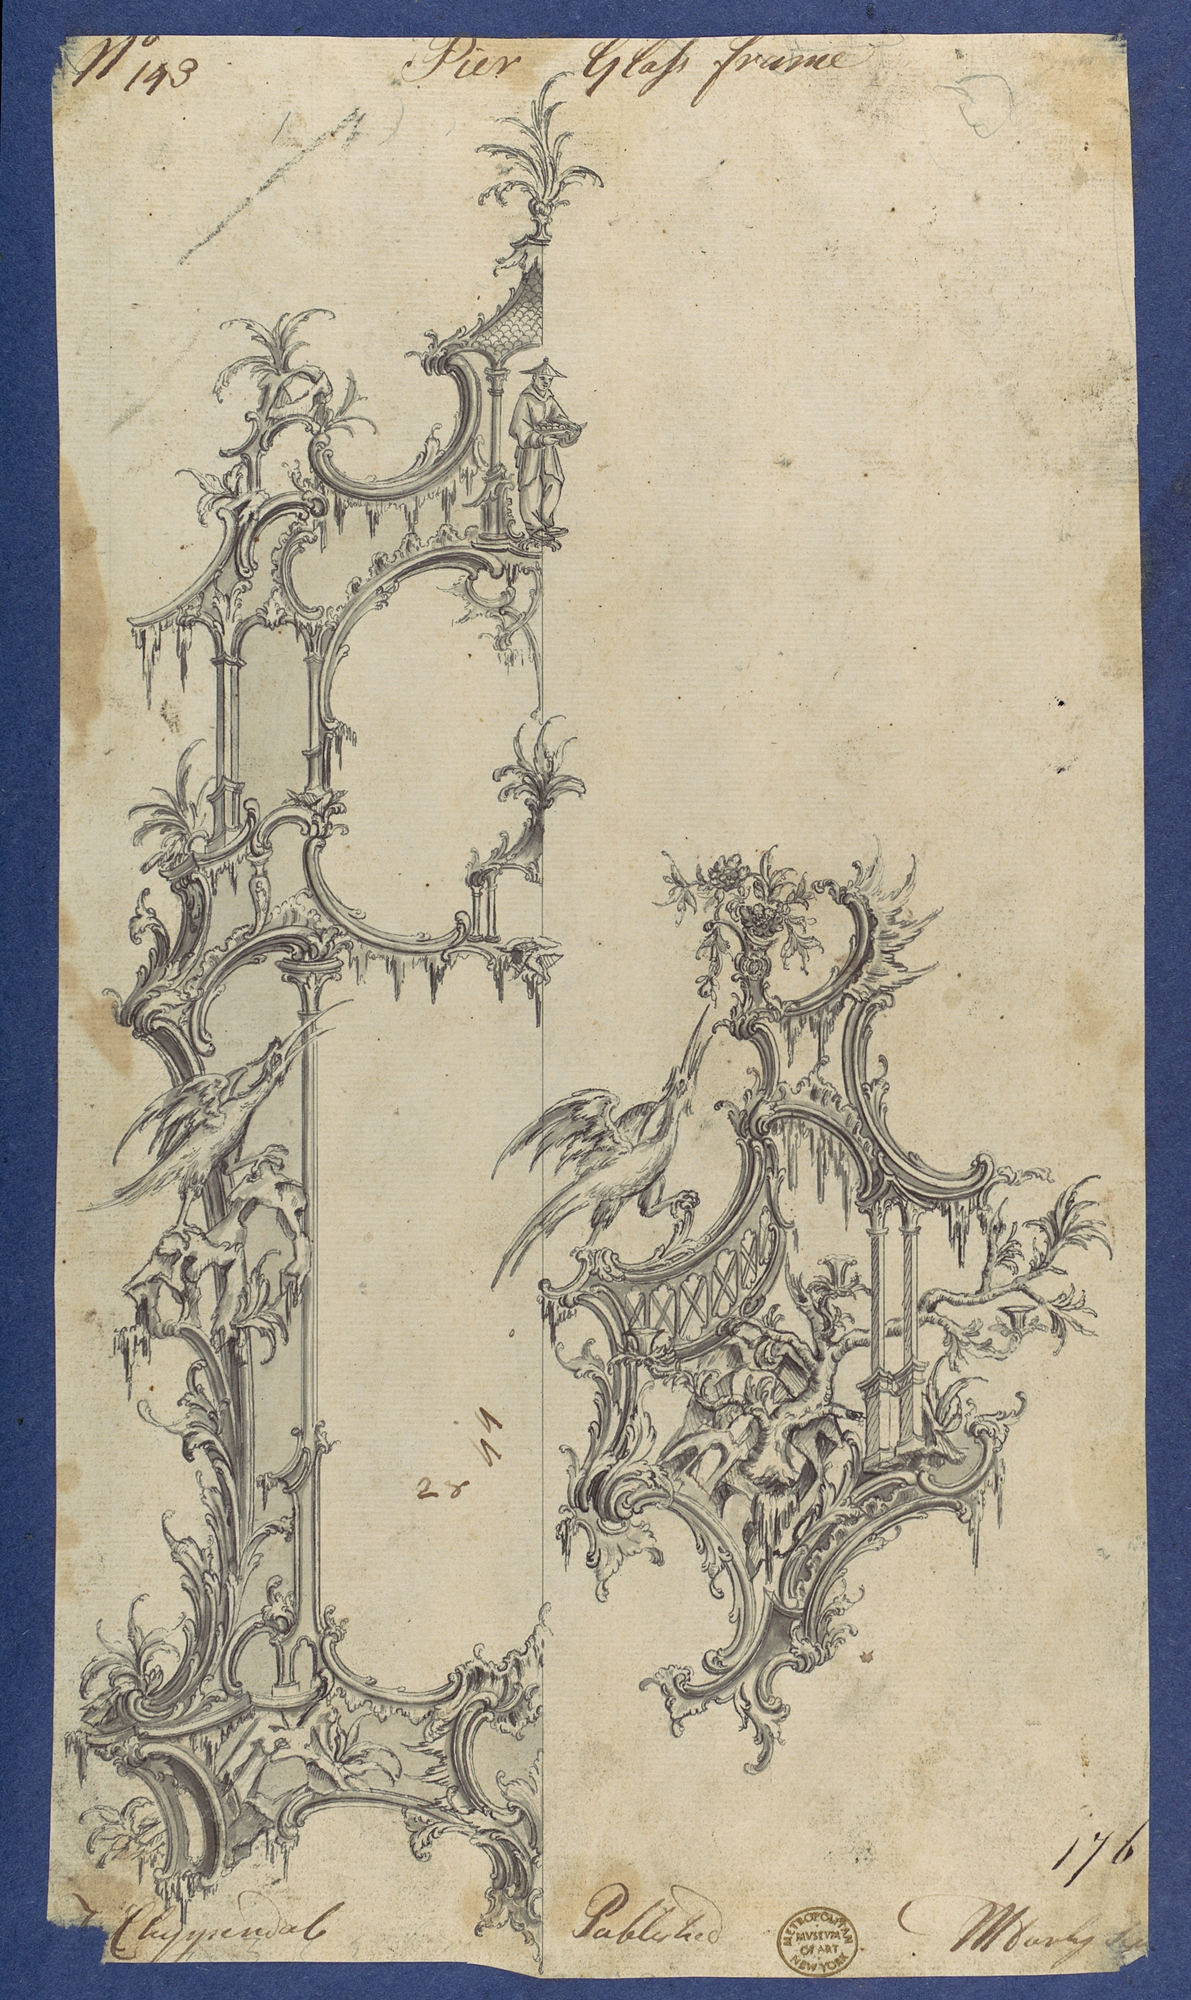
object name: drawing ornament architecture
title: Pier Glass Frames, in Chippendale Drawings, Vol. I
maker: thomas chippendale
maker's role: artist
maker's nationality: british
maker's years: 1718-1779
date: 1754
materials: ink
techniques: wash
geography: london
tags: birds,men,mirrors